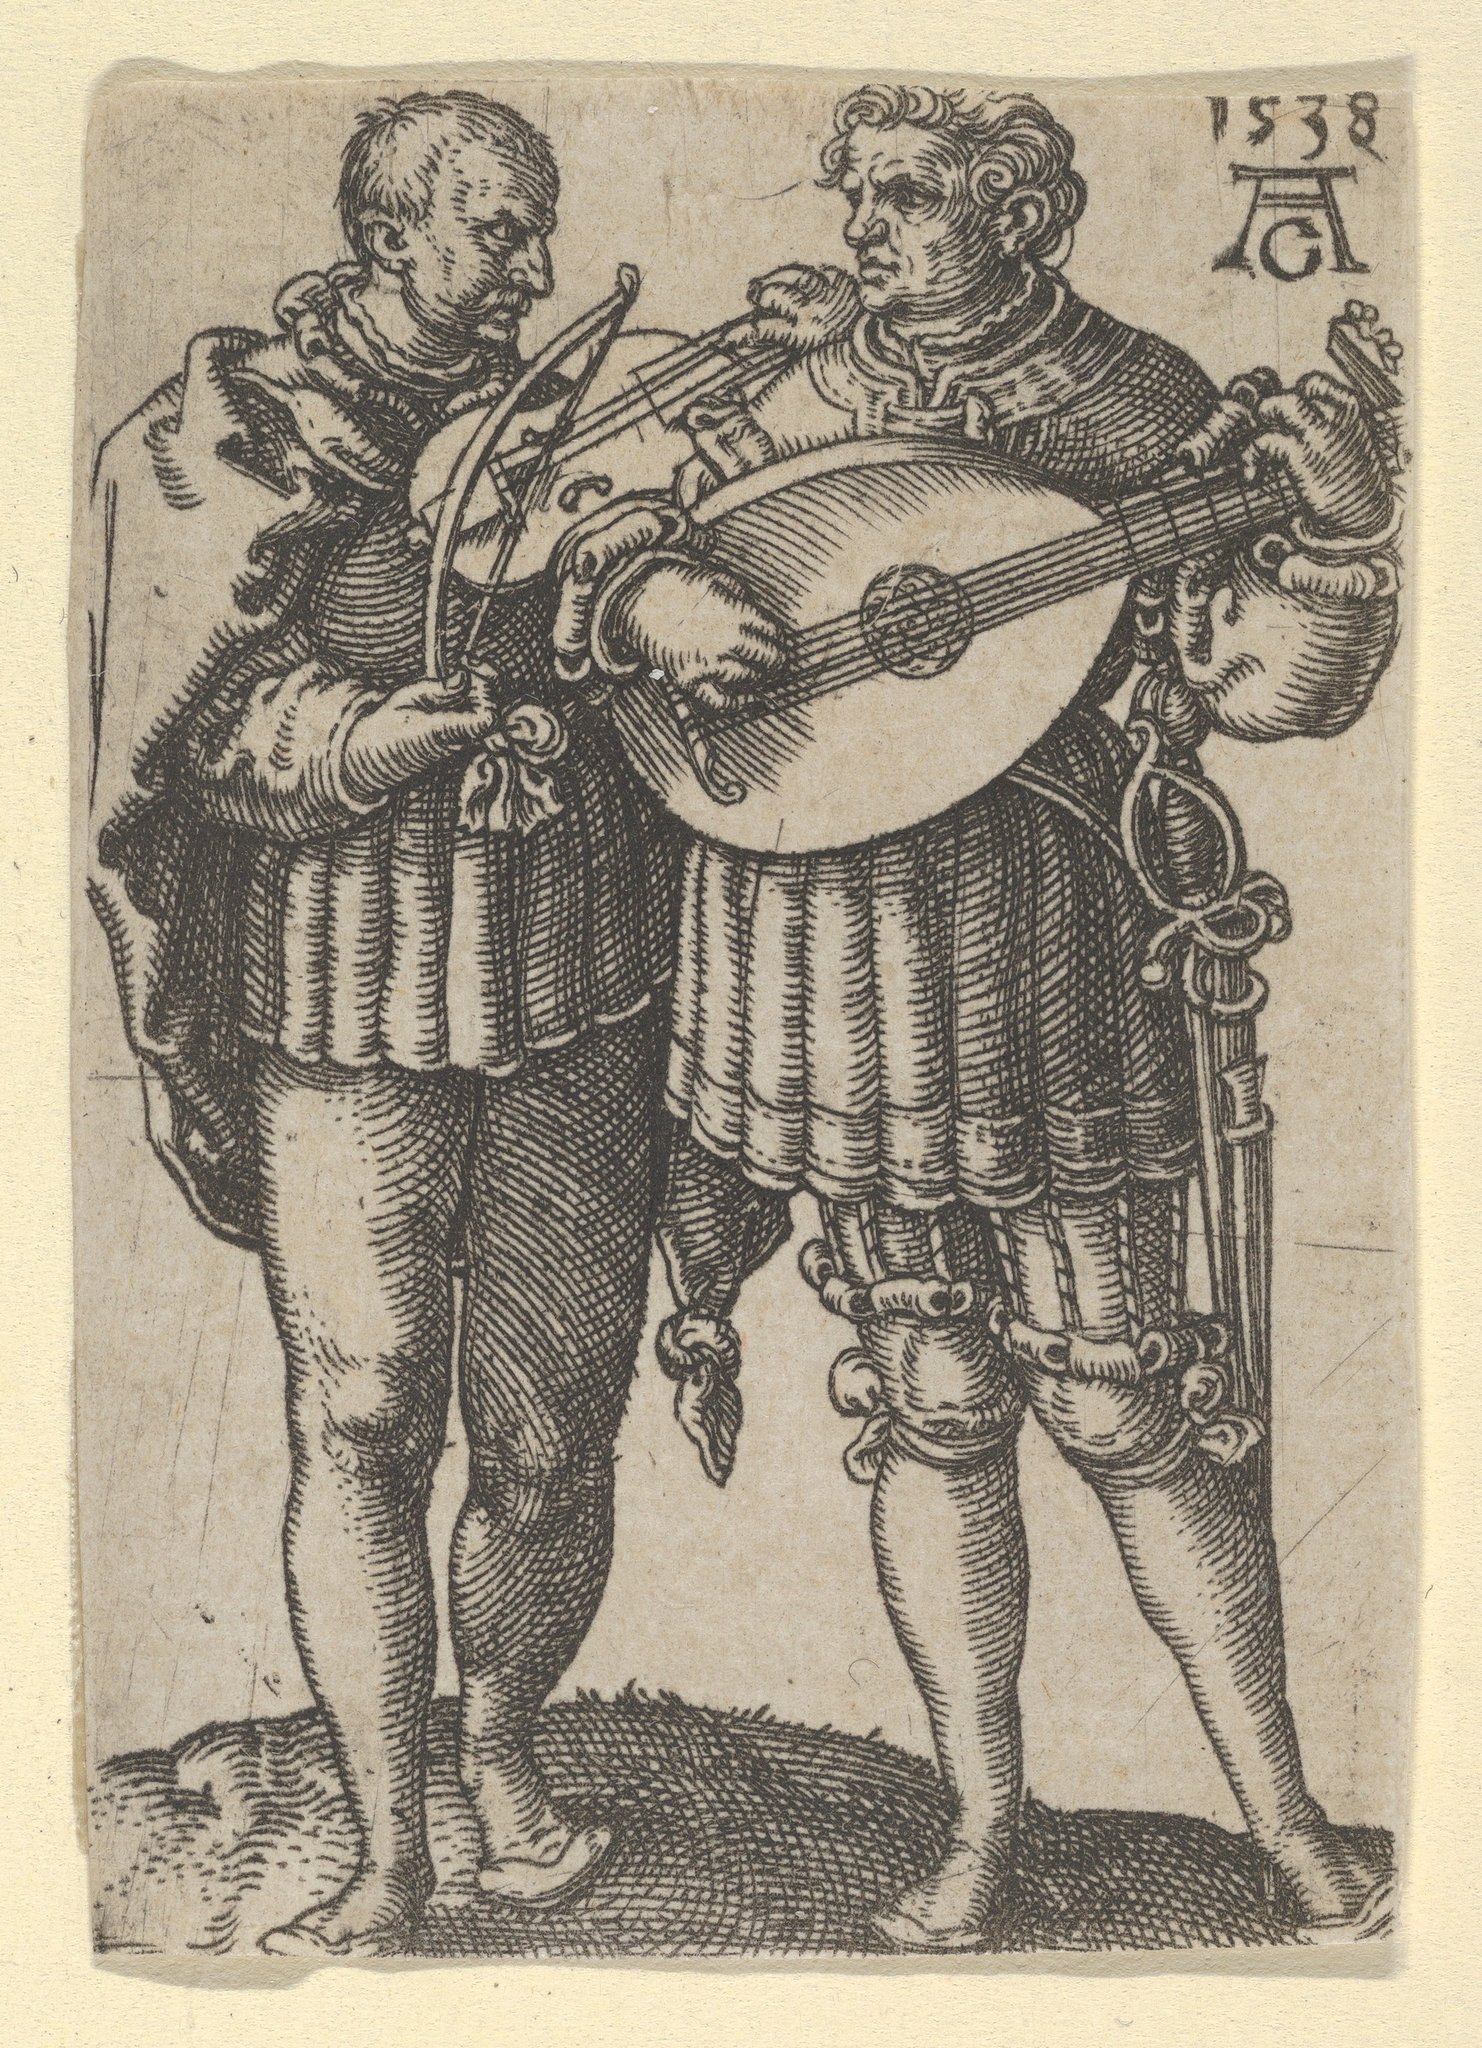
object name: print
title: Two Musicians Playing the Violin and the Lute, from "The Small Wedding Dancers"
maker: heinrich aldegrever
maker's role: artist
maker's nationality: german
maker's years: 1502-1561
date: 1538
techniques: engraving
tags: men,lutes,violins,musicians